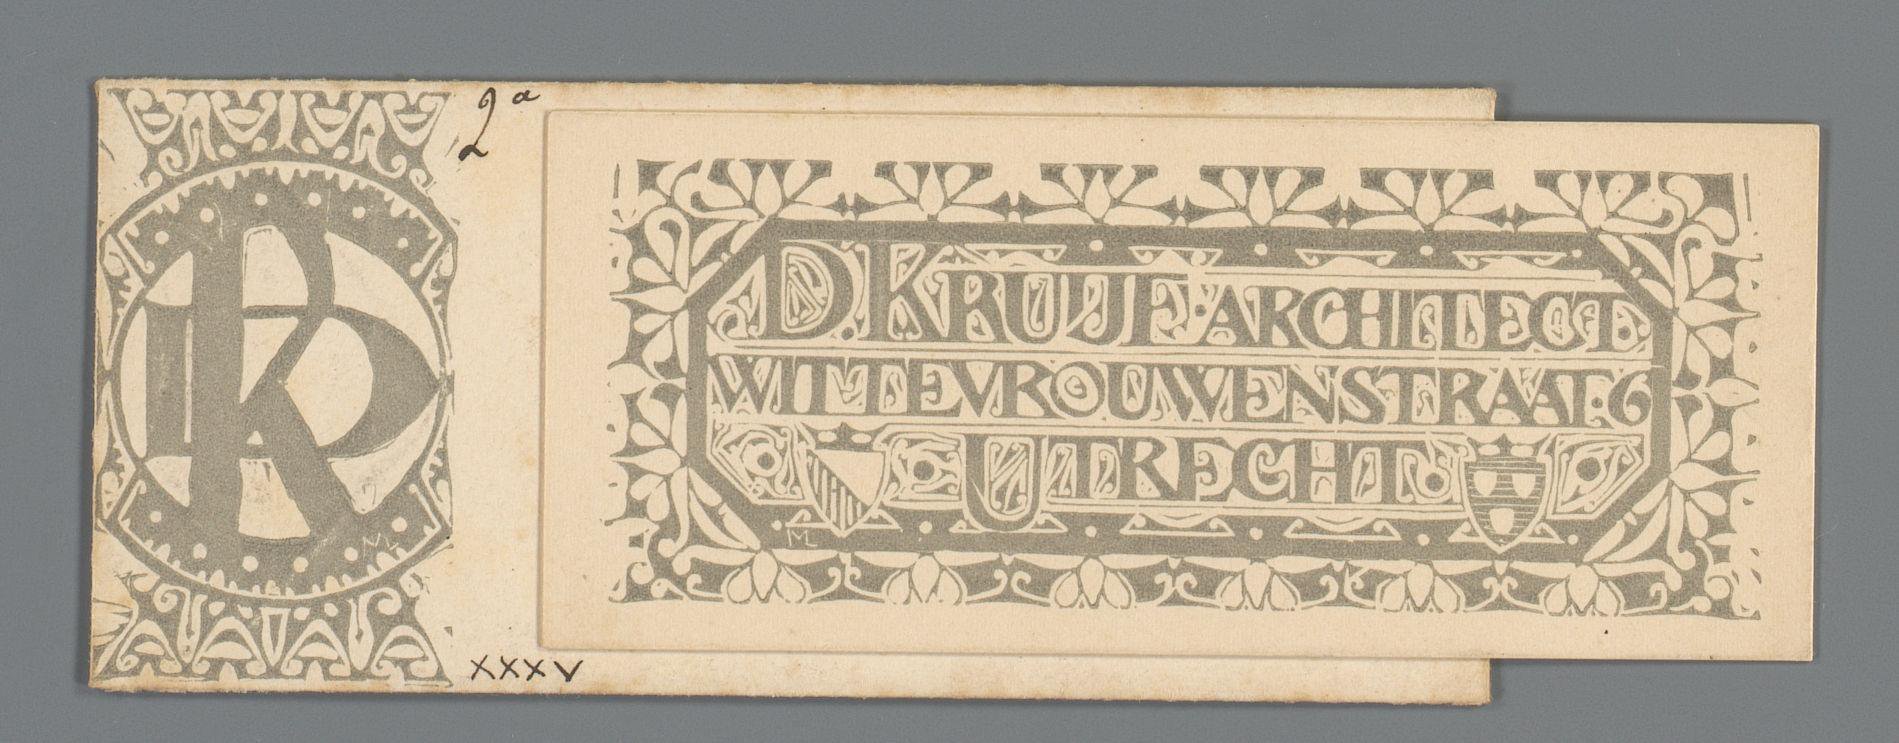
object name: business card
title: Adreskaart en envelop van D. Kruijf, architect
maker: mathieu lauweriks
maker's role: designer, draughtsman, print maker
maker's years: 1864-1932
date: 1896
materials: paper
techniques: woodcut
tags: zeist, visiting-card, calling-card, letter, envelope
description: De naam en het adres van de architect in een decoratief kader. Gelijmd op een bijbehorend smal envelopje met daarop het monogram DK.